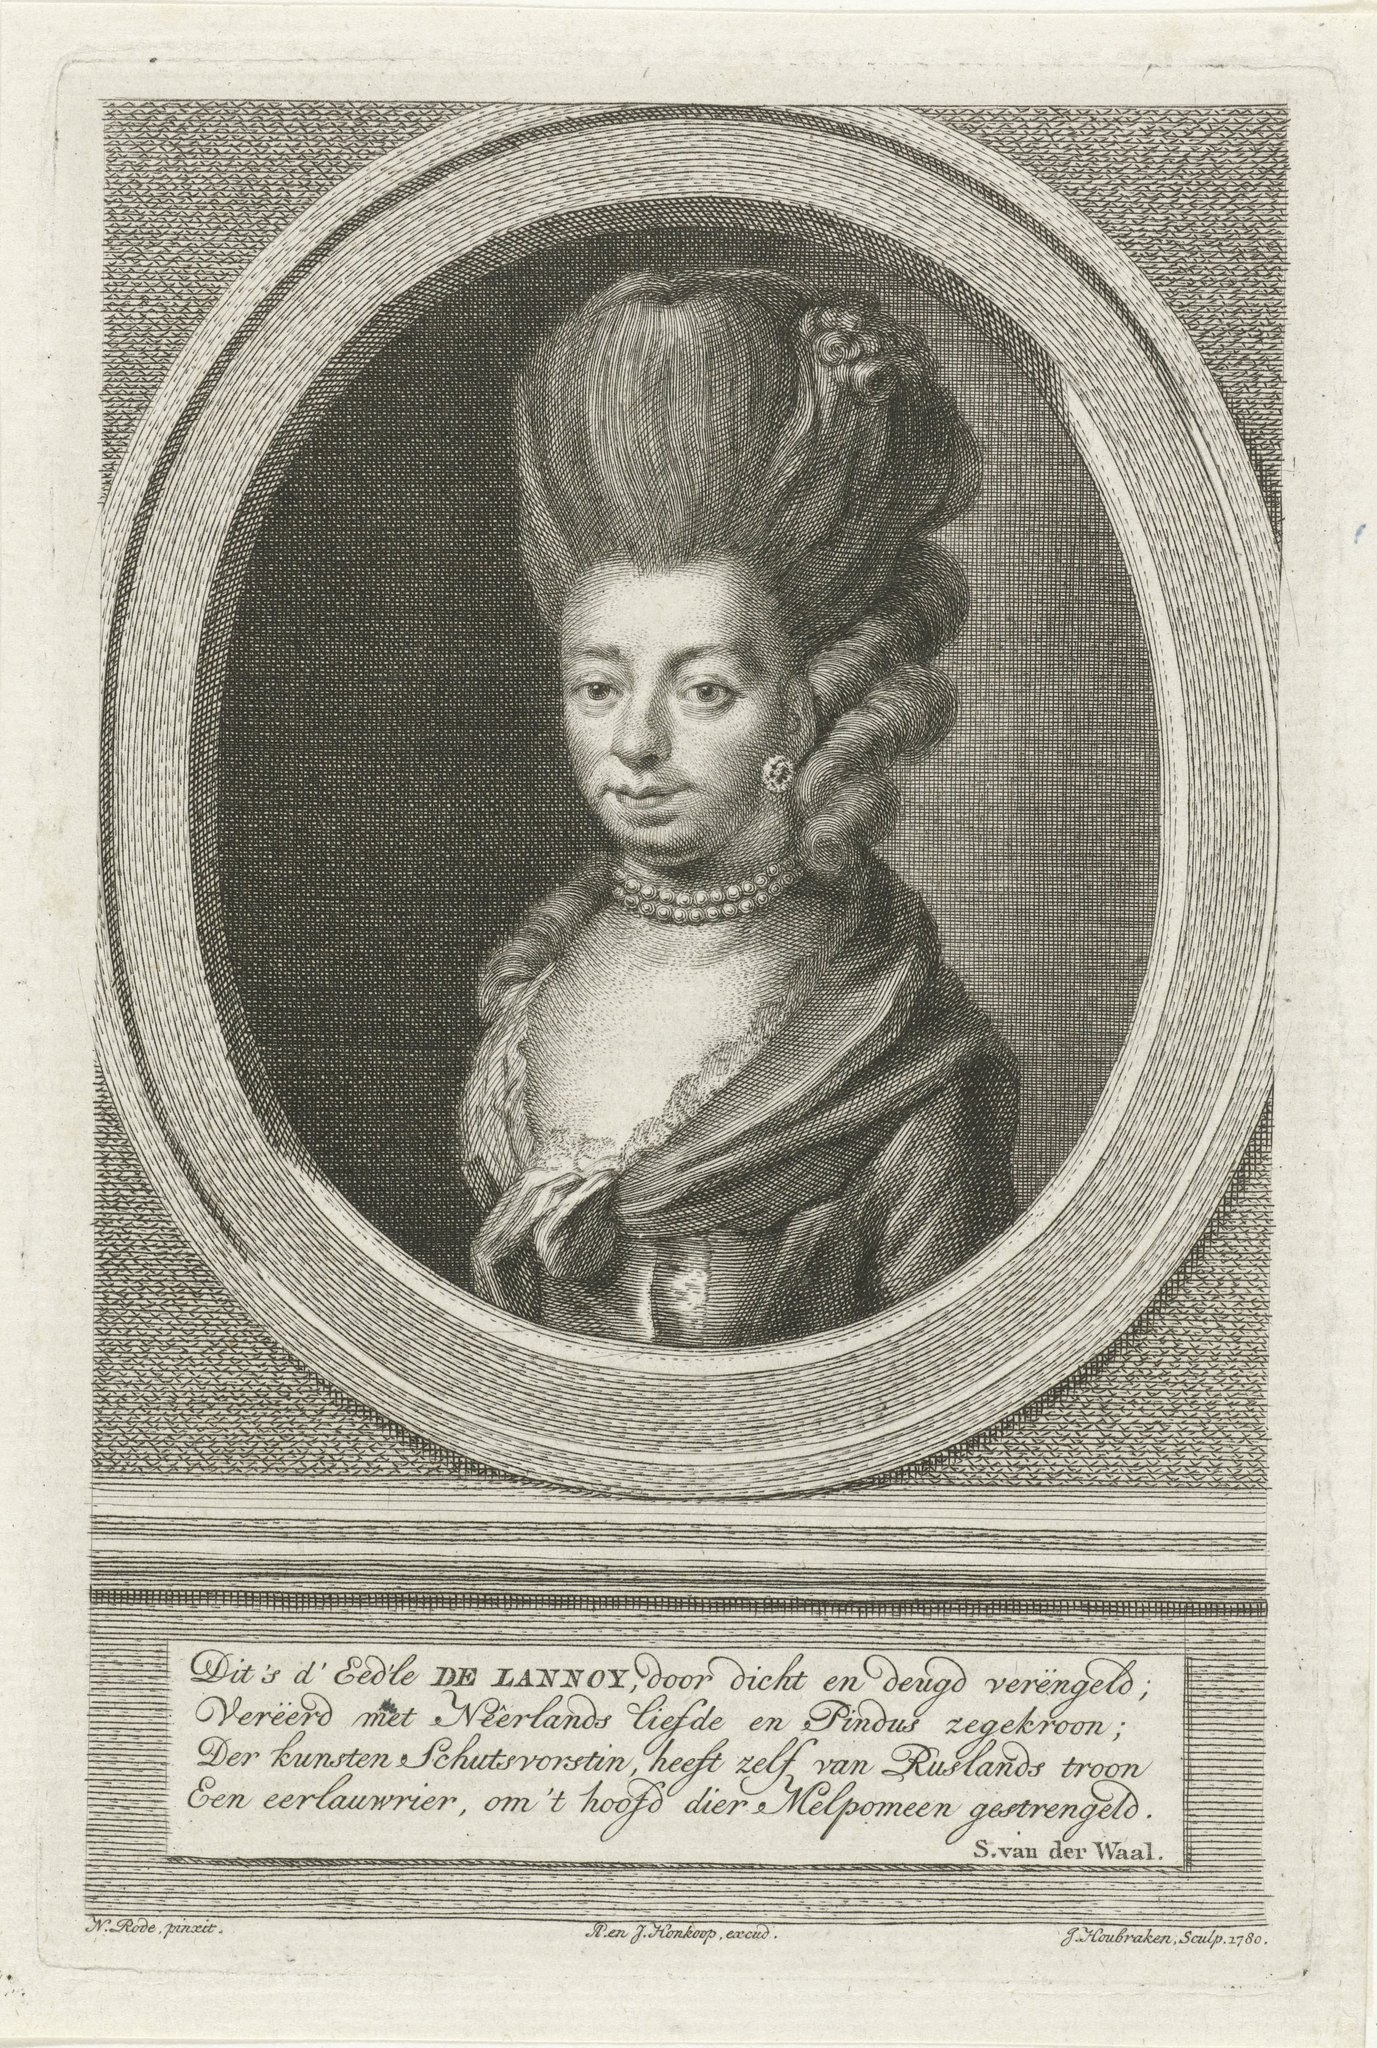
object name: print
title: Portret van Juliana Cornelia de Lannoy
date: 1780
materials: paper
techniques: engraving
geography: amsterdam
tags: geertruidenberg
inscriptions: collector's mark: Lugt 240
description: Buste naar links van Juliana Cornelia de Lannoy in een ovaal. Het portret rust op een plint waarop een vierregelig vers in het Nederlands.